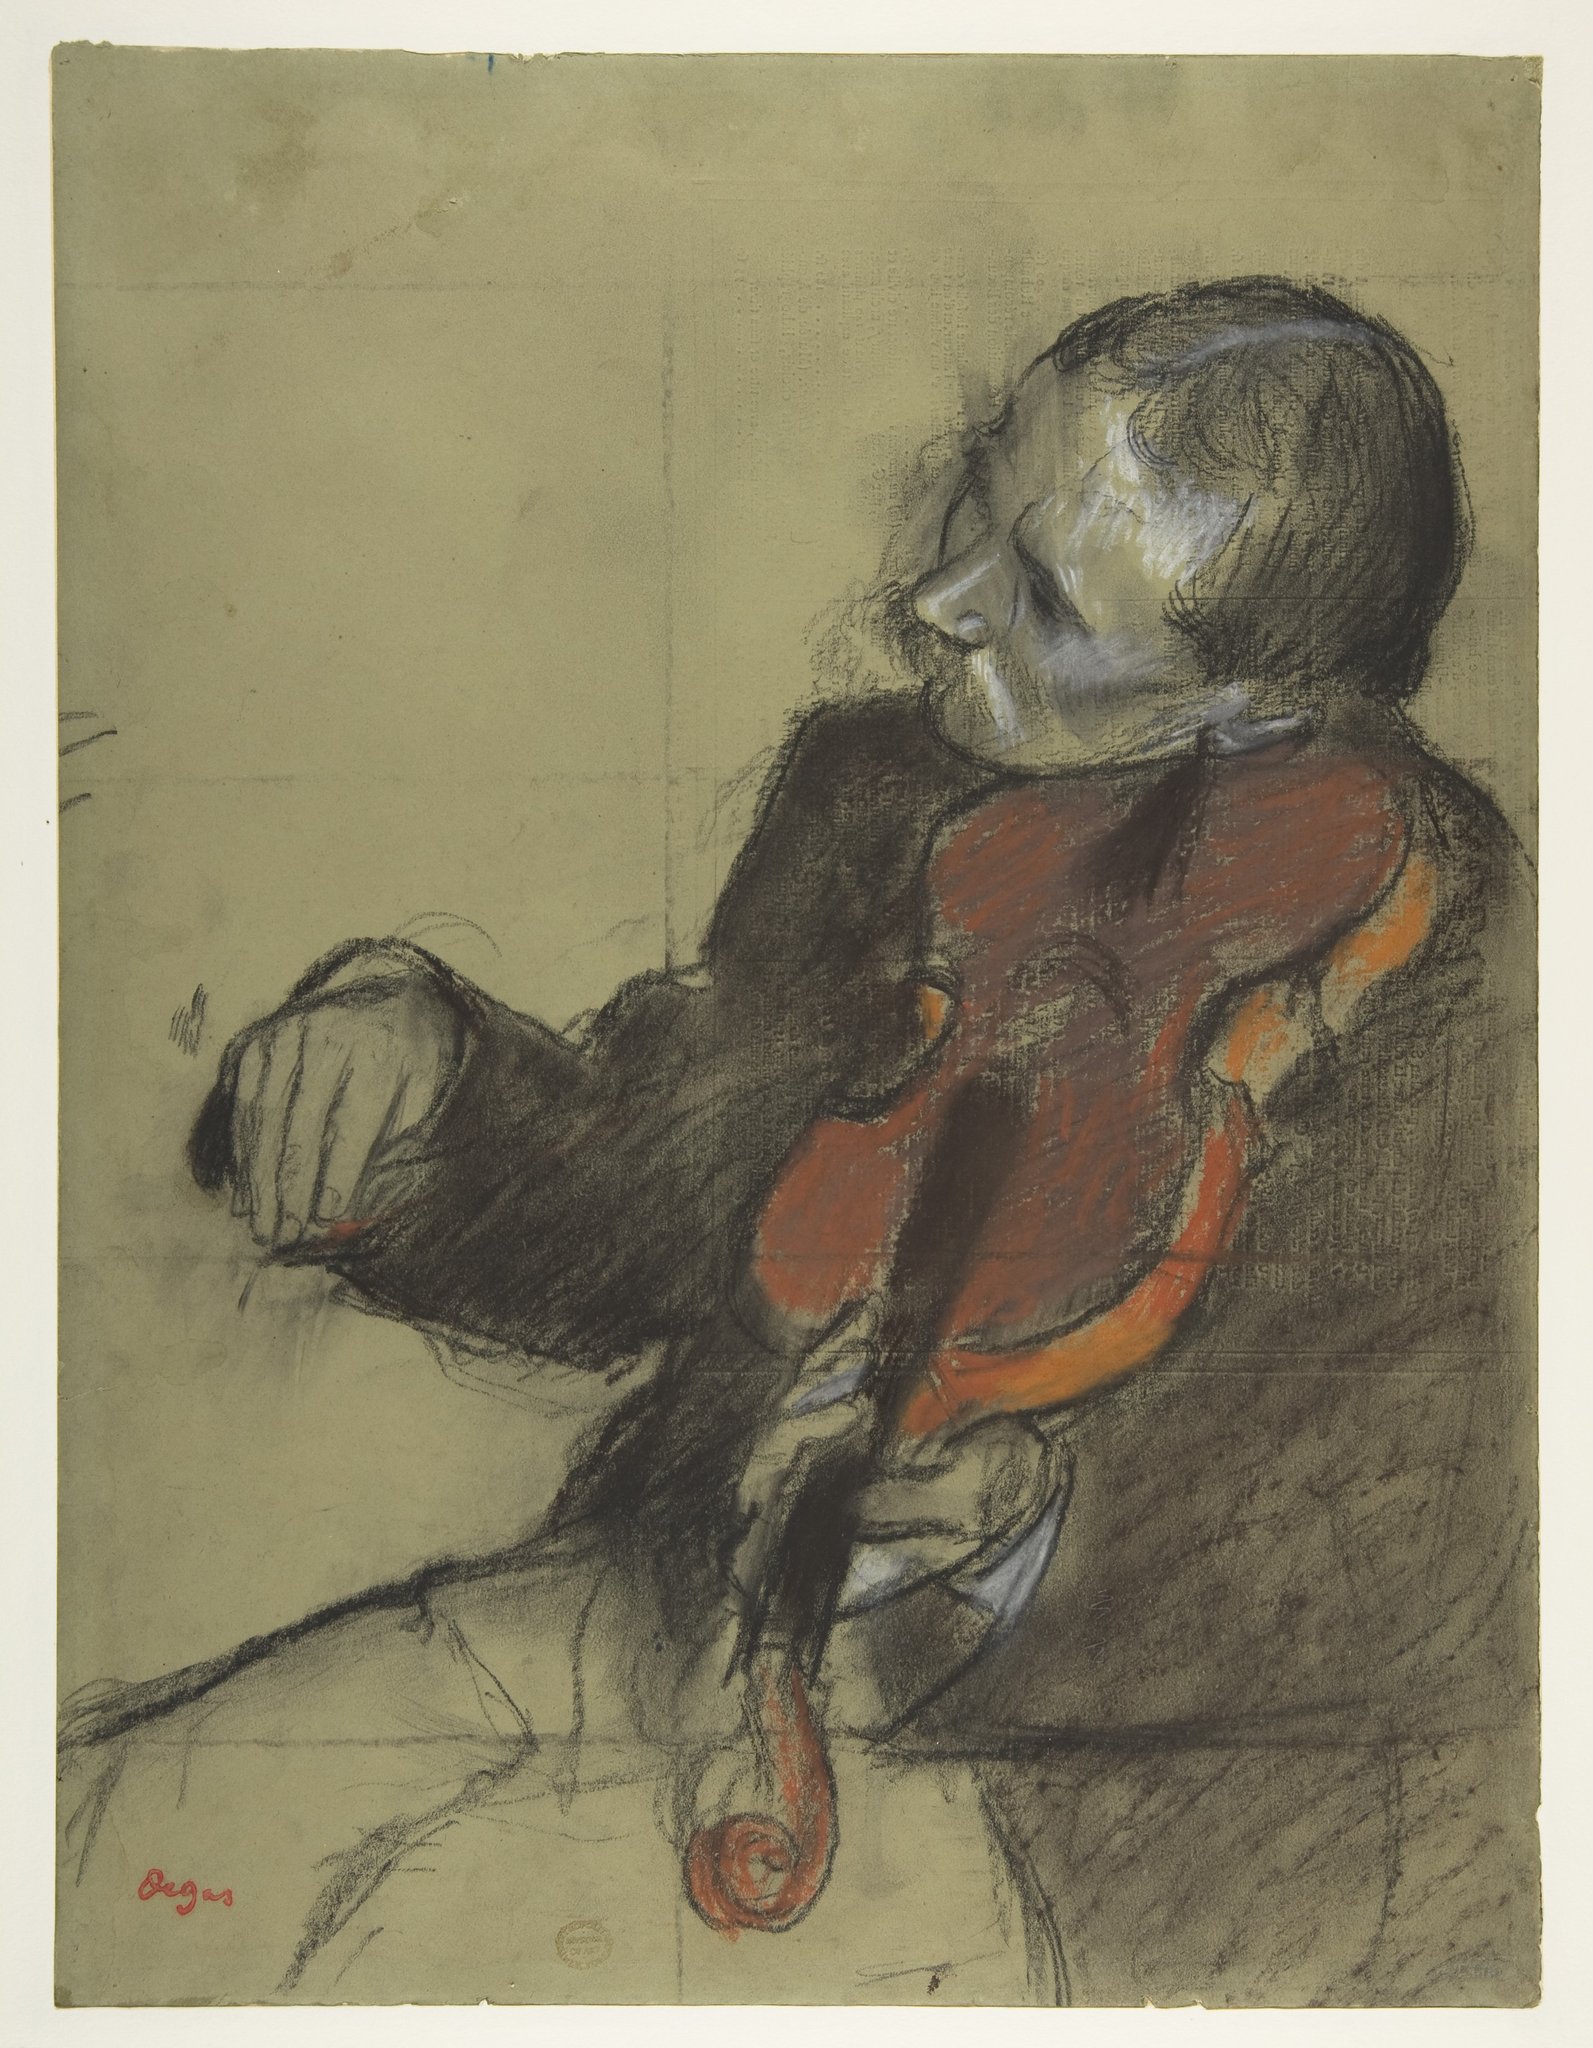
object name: drawing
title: Violinist, Study for "The Dance Lesson"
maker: edgar degas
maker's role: artist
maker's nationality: french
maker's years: 1834-1917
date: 1878-1879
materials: charcoal, pastel, paper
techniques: letterpress printing, drawing, transfer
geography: france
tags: men,violins,musicians